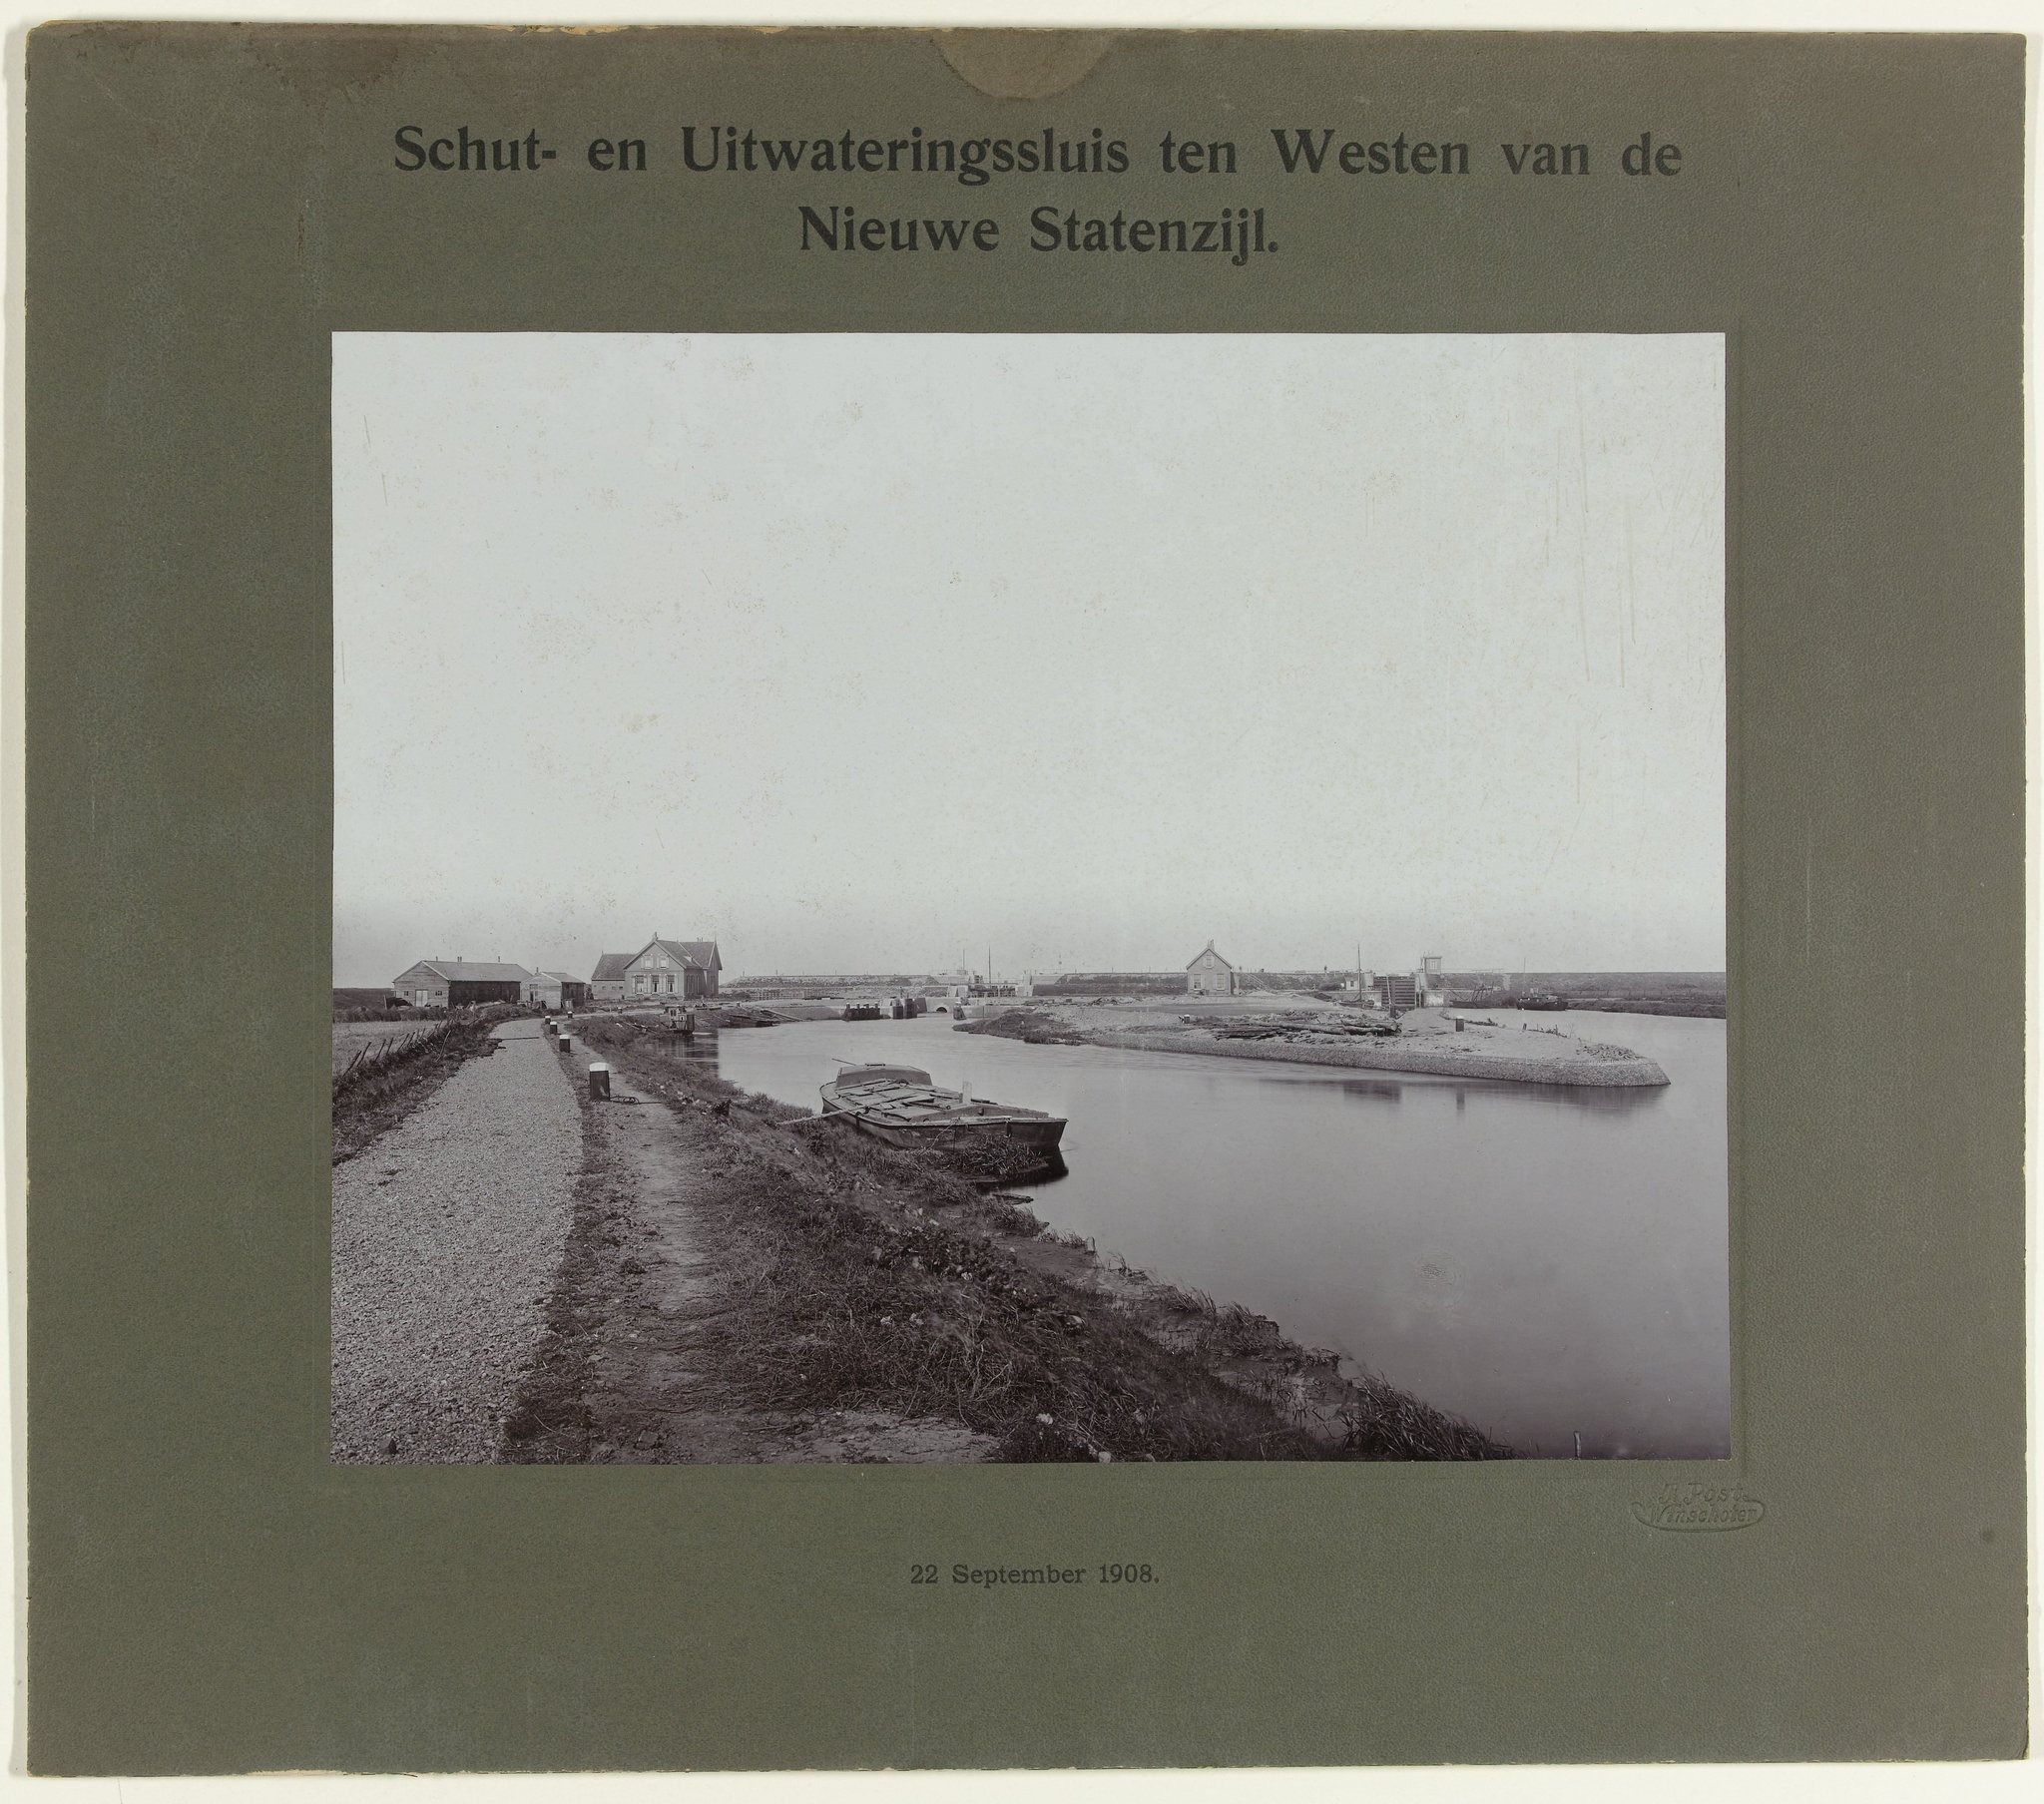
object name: photograph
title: Schut- en Uitwateringssluis ten Westen van de Nieuwe Statenzijl 1907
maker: tonnis post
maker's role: fotograaf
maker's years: 1877-1930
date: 1908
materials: cardboard, paper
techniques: collodion silver print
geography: winschoten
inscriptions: date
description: Een van 8 foto's in cassette aangaande een sluis (bij Nieuwe Statenzijl). Foto op blauwgrijs karton geplakt, cassette: paars / bruin. Gedateerd. Opmerking: zie NG-1976-36-B-1 t/m 8.